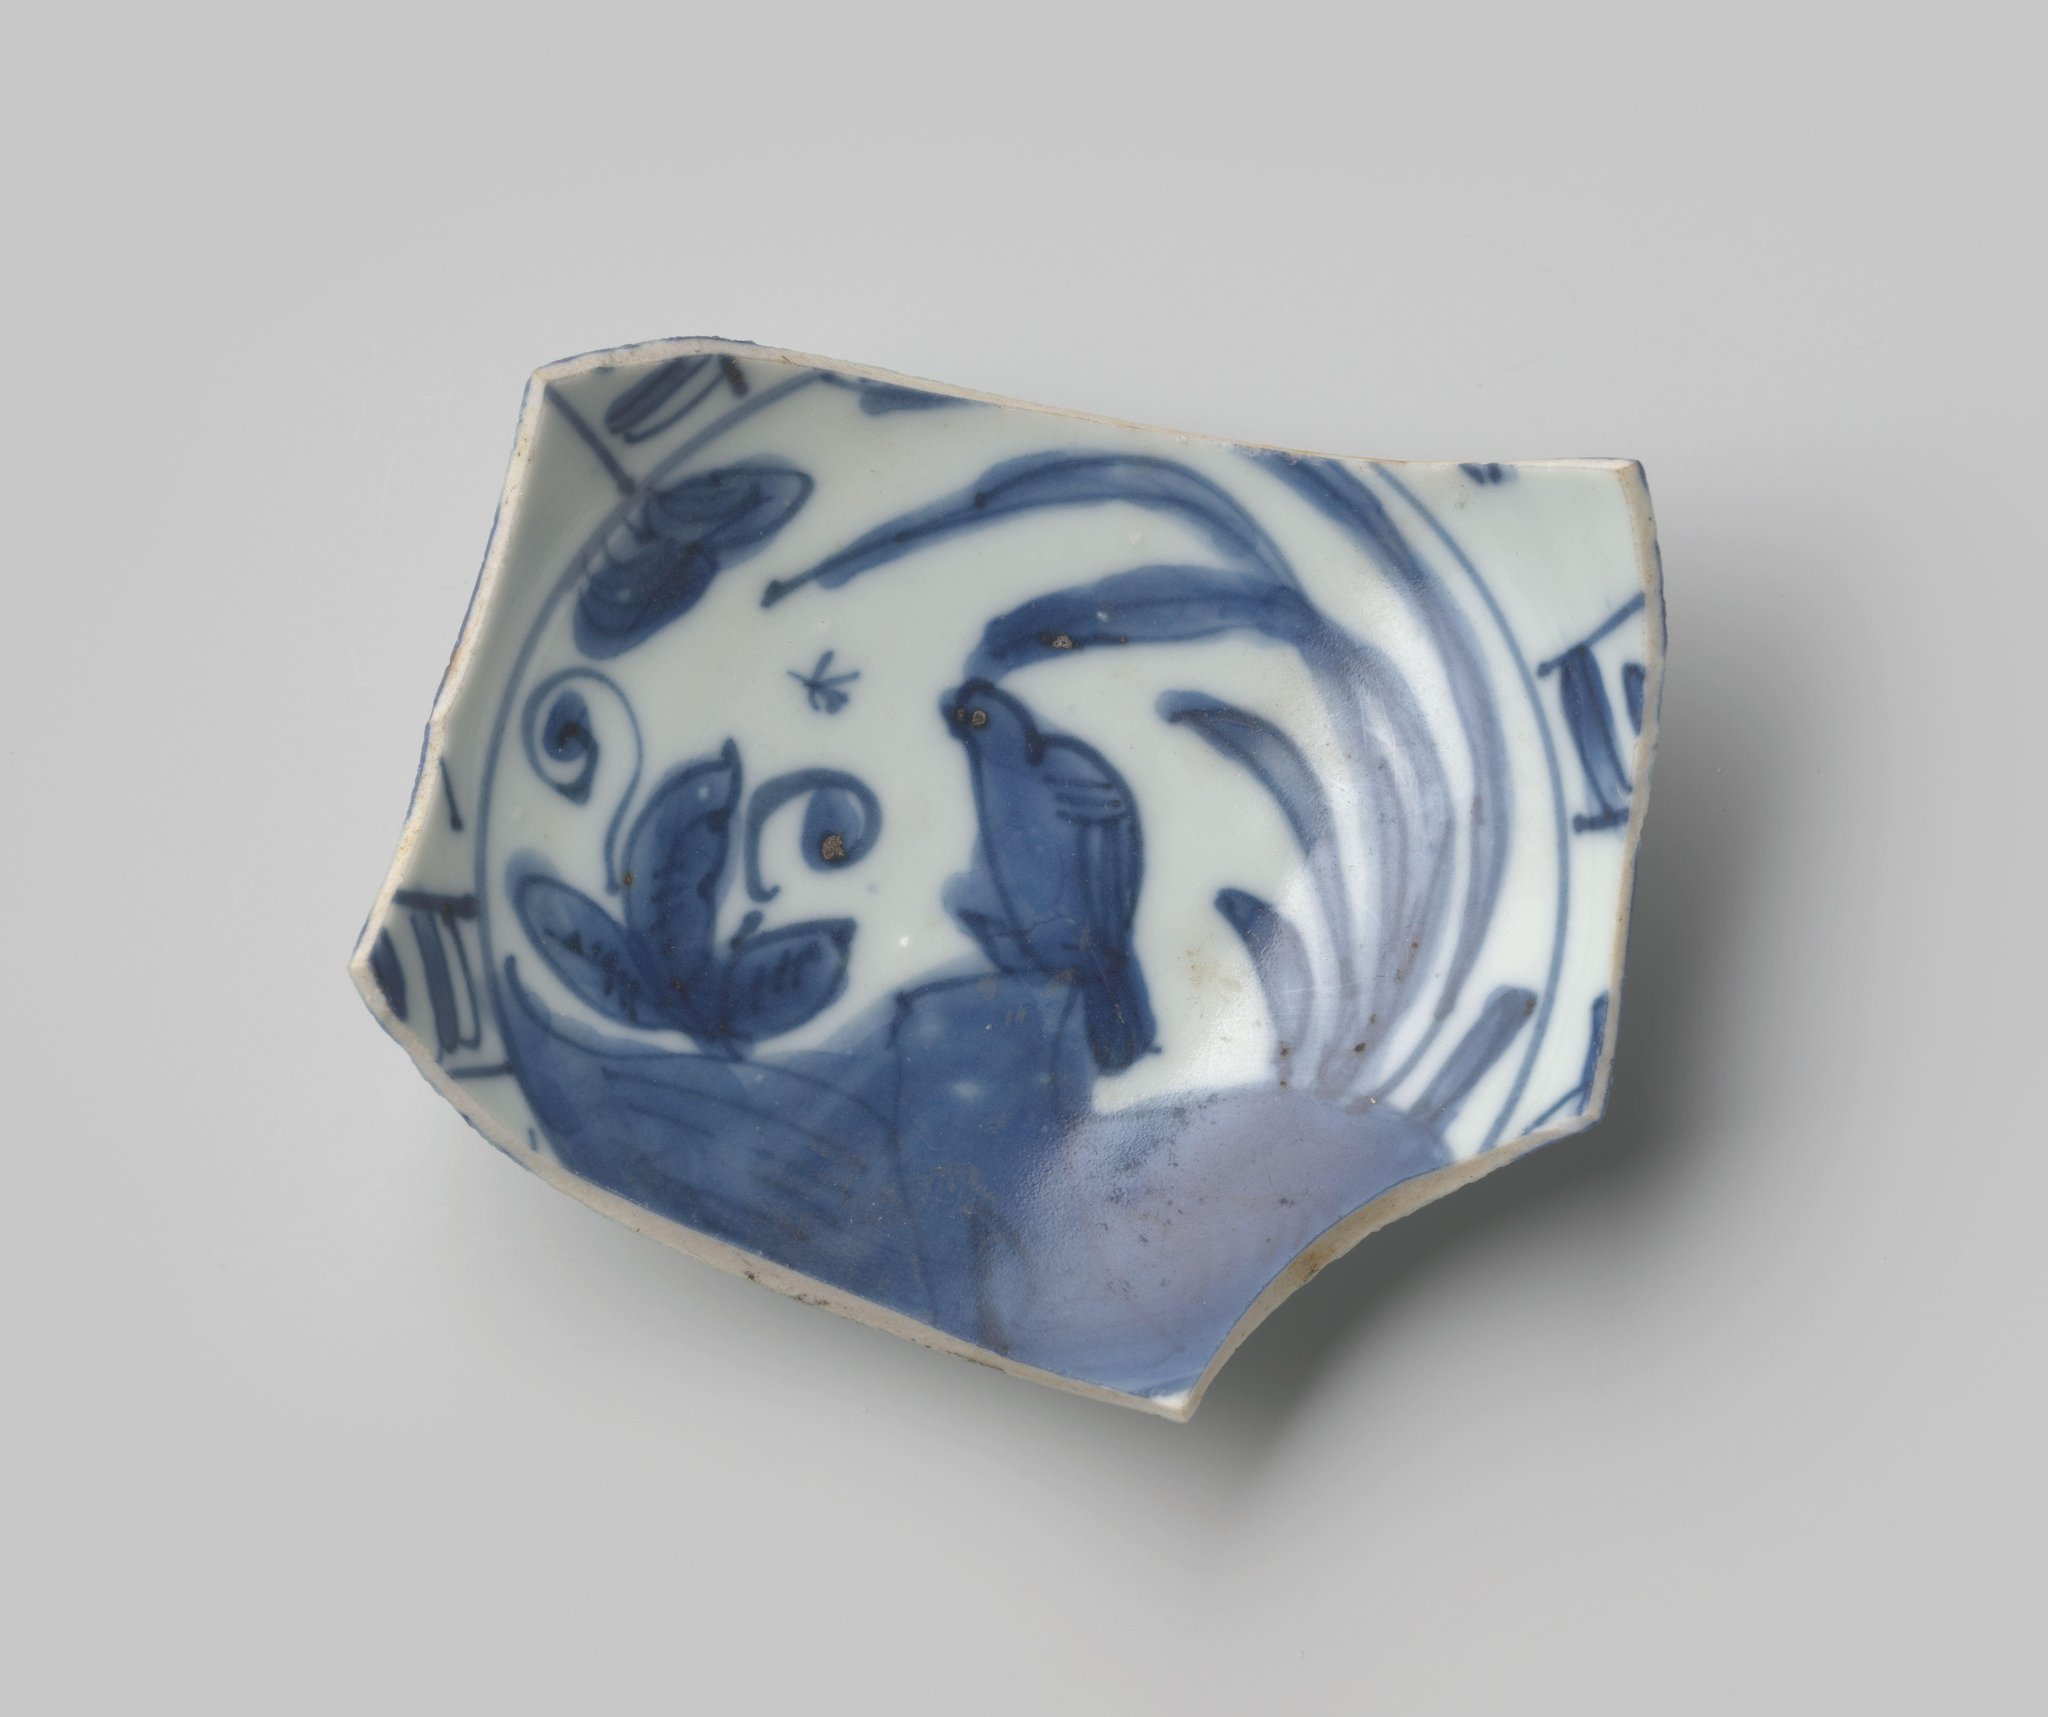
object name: bowl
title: Scherf van een kom uit V.O.C.-schip de 'Witte Leeuw'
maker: Anonymous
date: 1613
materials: bone china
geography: jingdezhen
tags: verenigde oostindische compagnie, sint-helena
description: Scherf kraakporseleinen kom uit V.O.C.-schip de 'Witte Leeuw'. Bodemfragment.